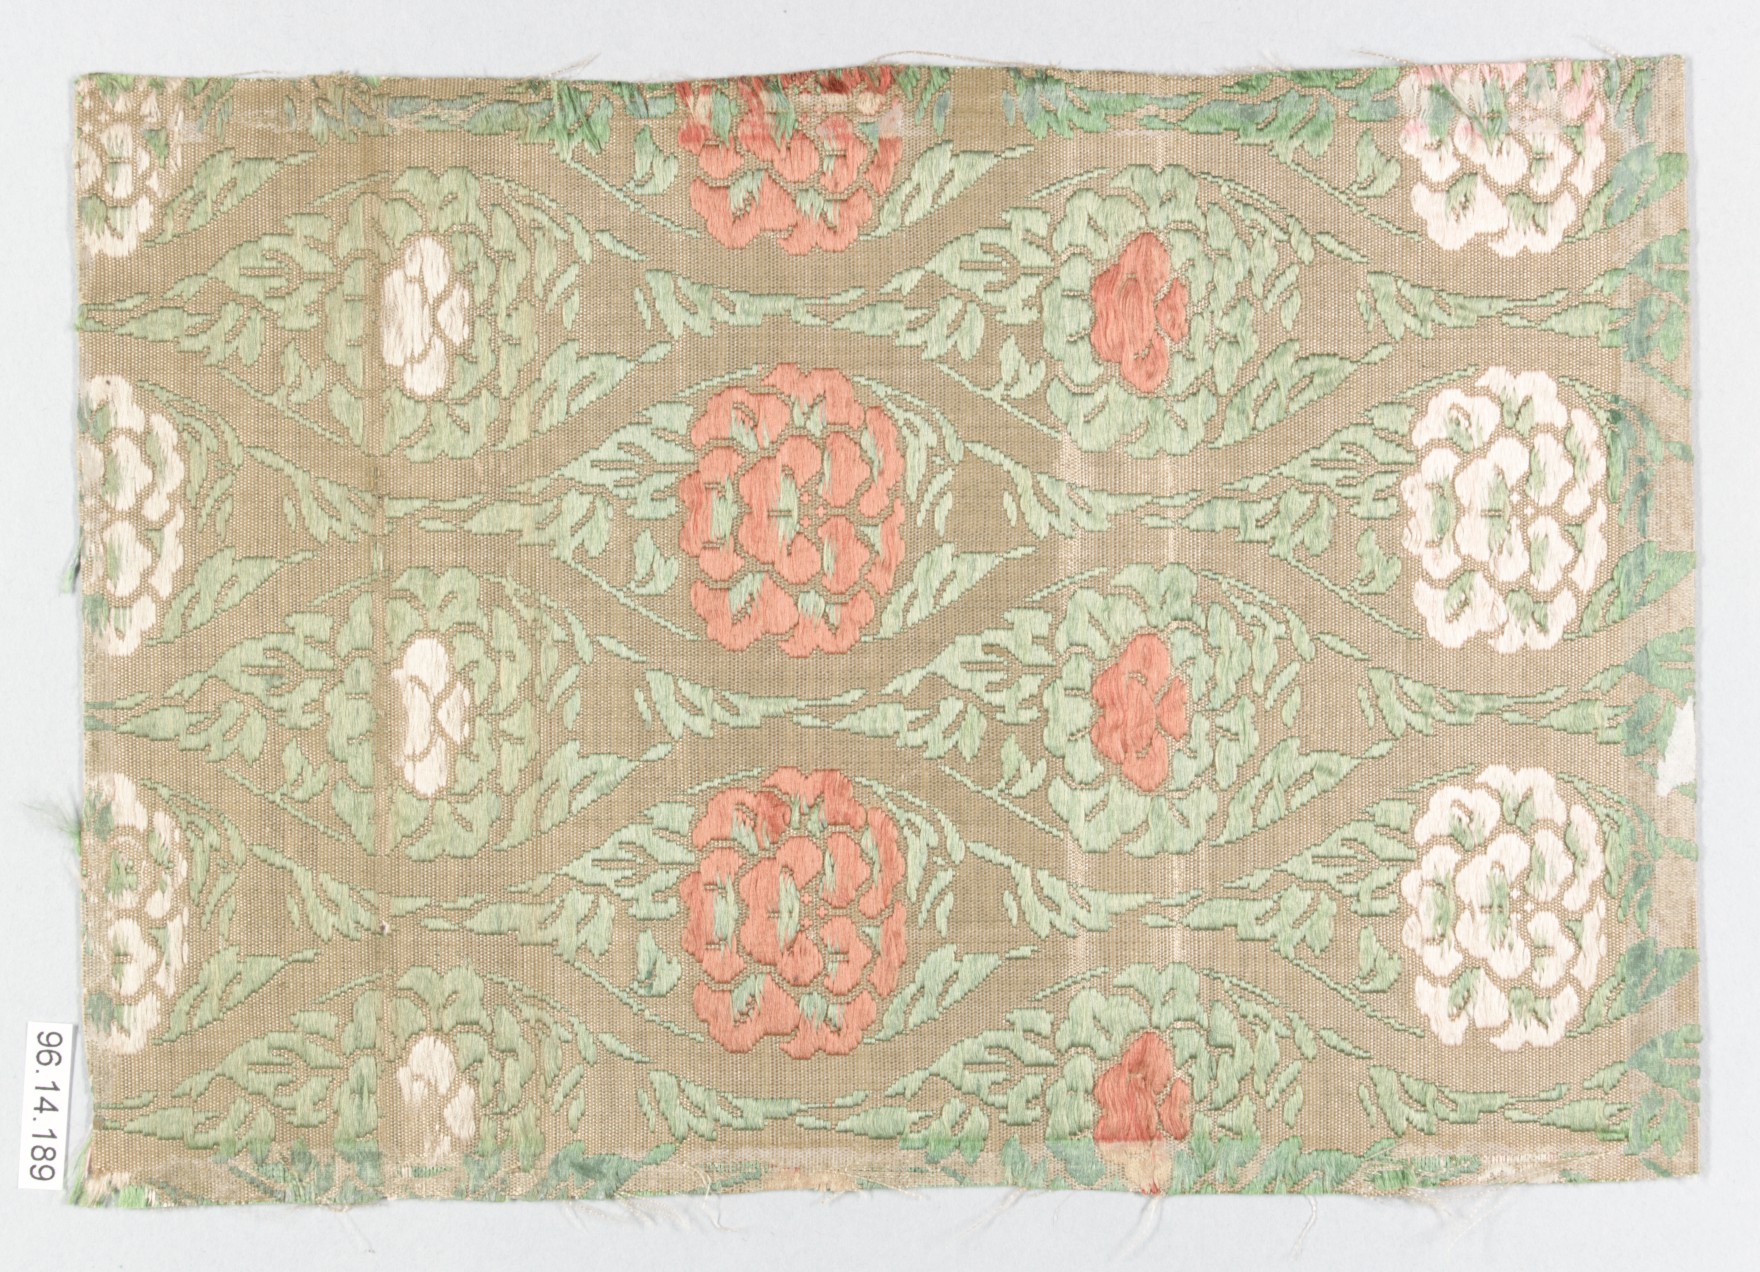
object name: piece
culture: japanese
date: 1701-1900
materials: silk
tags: flowers